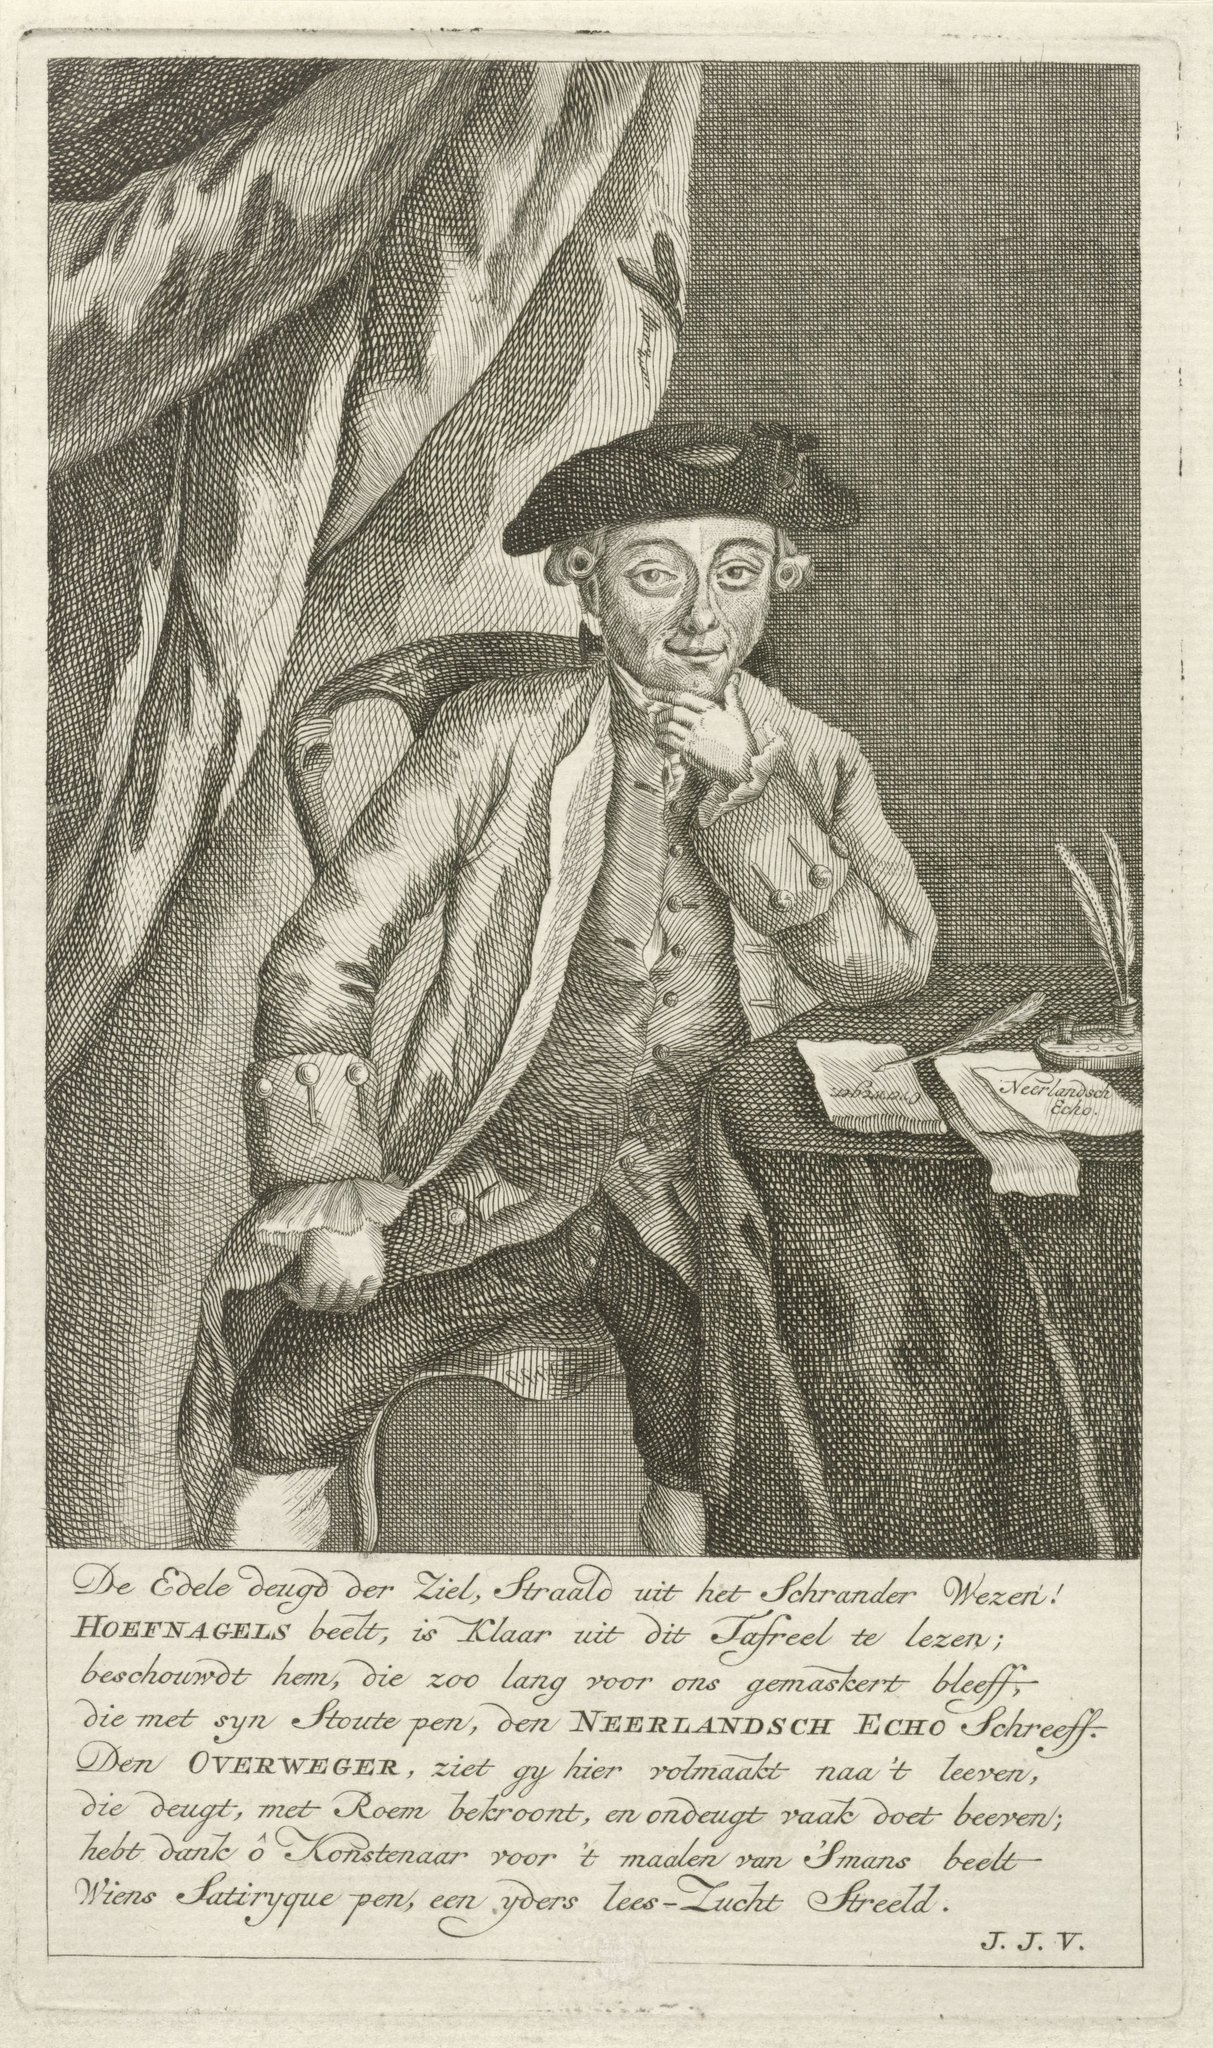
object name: print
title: Portret van Nicolaas Hoefnagel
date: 1770-1771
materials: paper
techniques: engraving, etching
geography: northern netherlands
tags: rotterdam, utrecht, writer, poet, author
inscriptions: collector's mark: Lugt 2228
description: Portret van de schrijver Nicolaas François Hoefnagel, auteur van Neerlandsch Echo (1770) en De Nederlandsche Overweeger (1771). De schrijver zittend achter een schrijftafel. In het onderschrift een vers van acht regels.